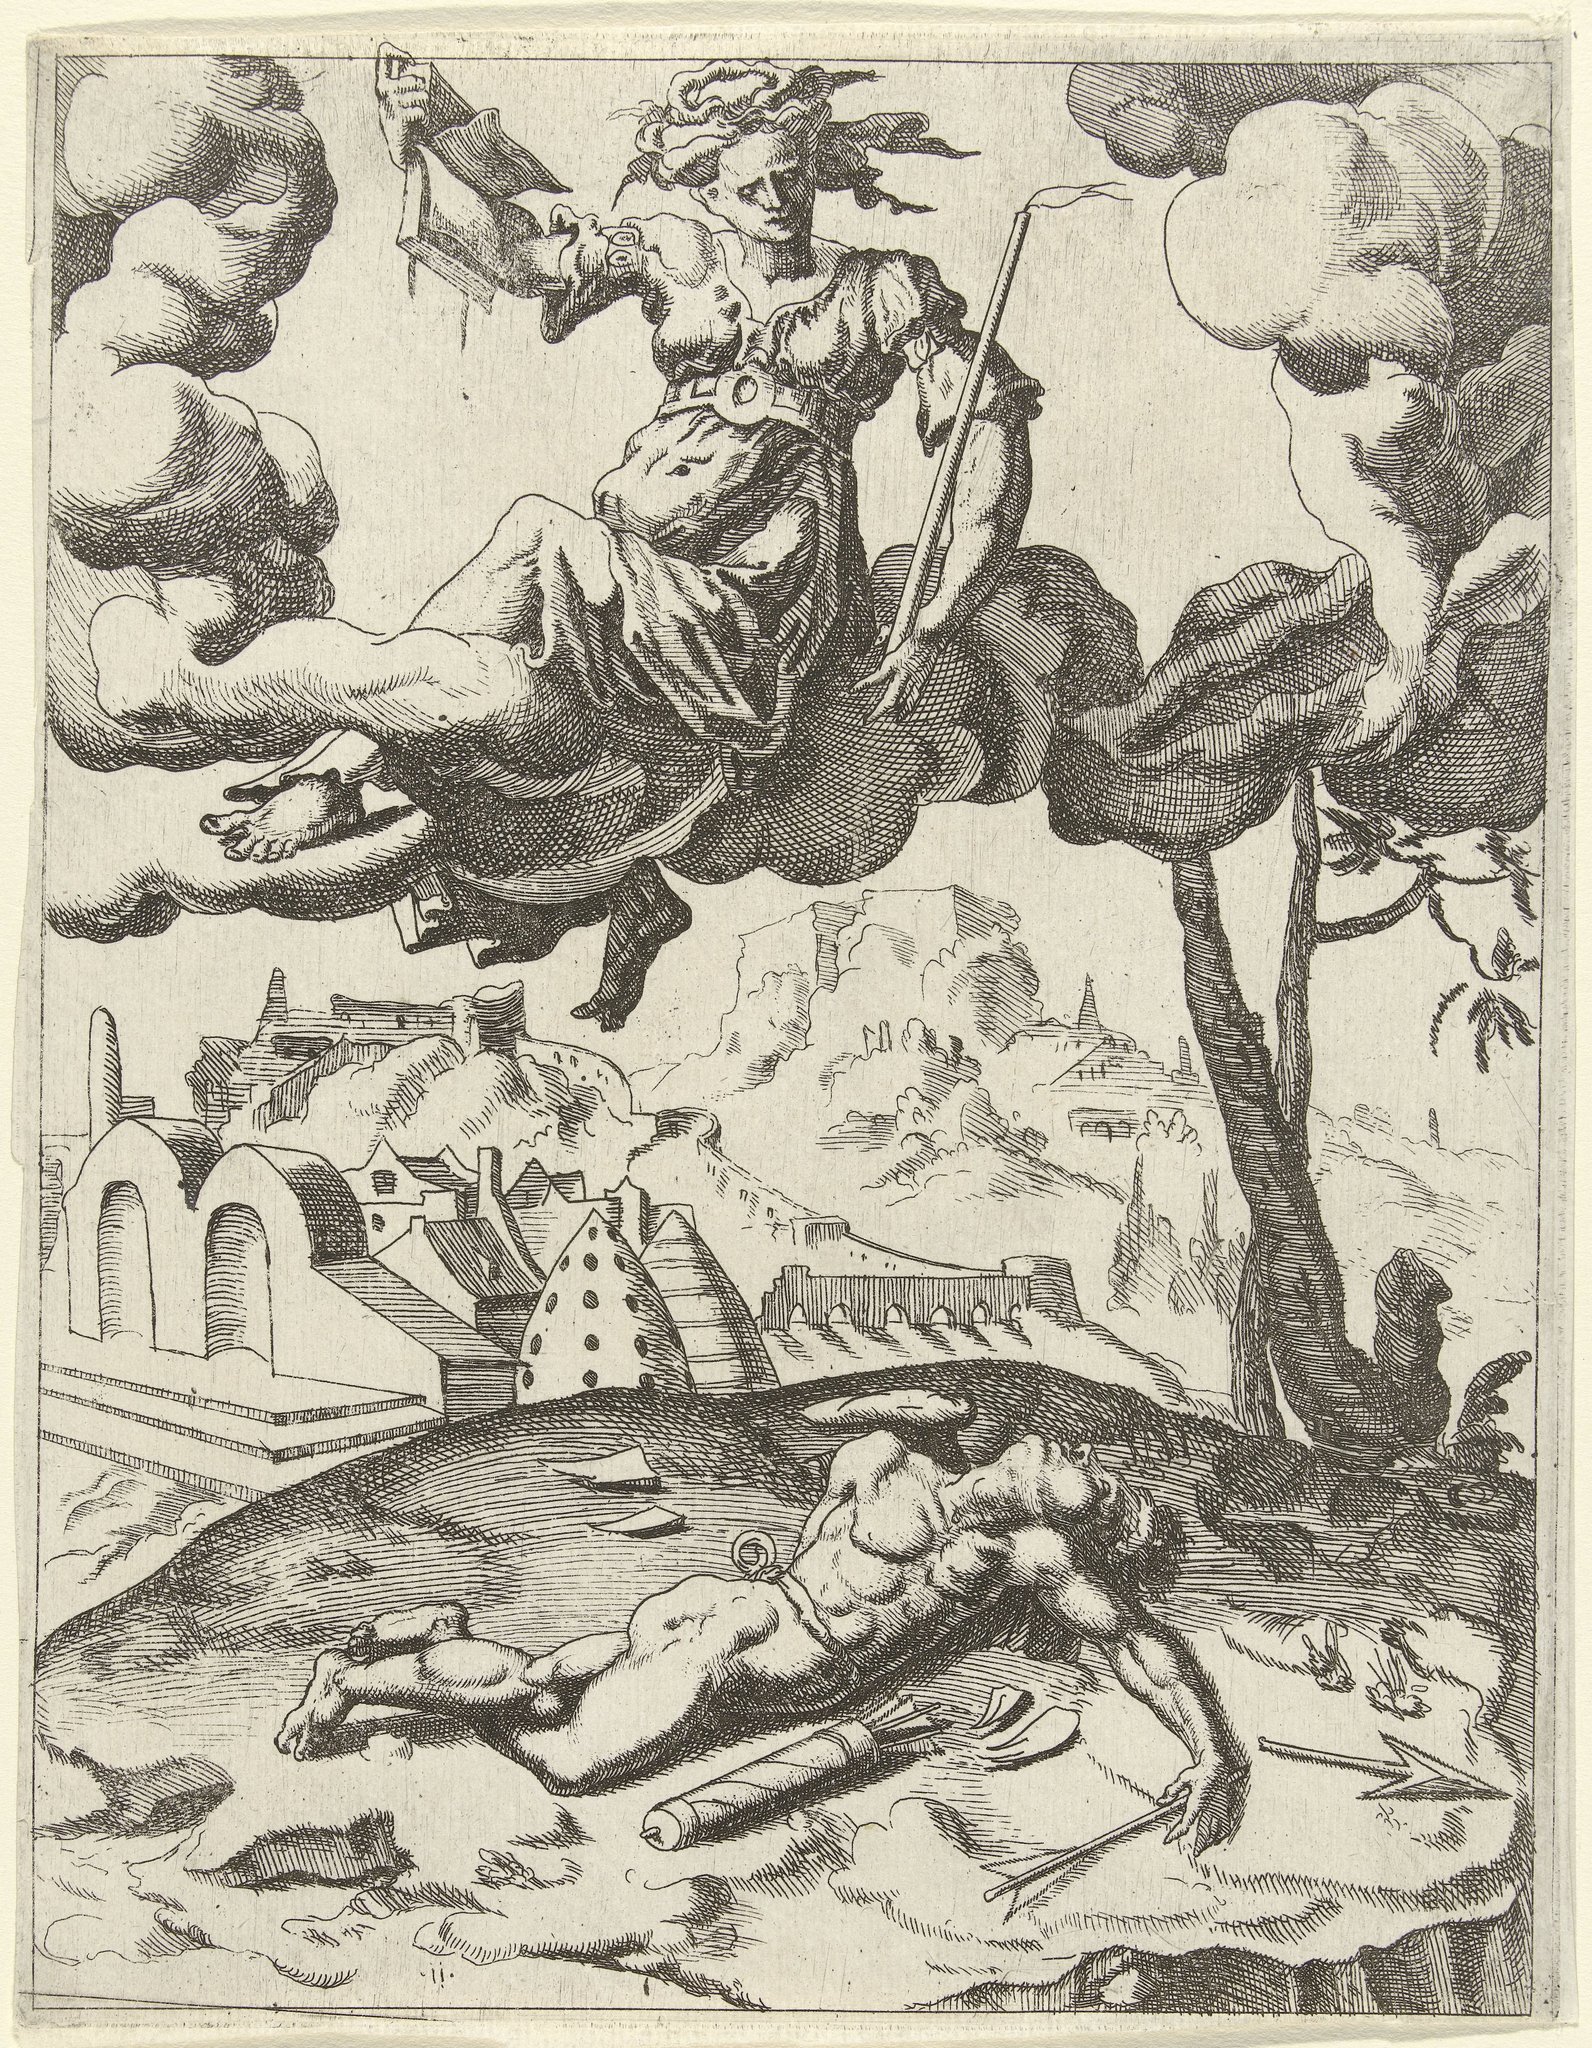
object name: print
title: Geloof overwint de zinnelijke liefde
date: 1532-1590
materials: paper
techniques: etching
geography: haarlem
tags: faith, 'fides'; 'fede', 'fede catholica', 'fede christiana', 'fede christiana catholica' (ripa) ~ one of the three theological virtues, 'trionfo della castità', 'triumphus pudicitiae'; 'carro della castità' (ripa), (story of) cupid, amor (eros)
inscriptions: collector's mark: Lugt 2760, collector's mark: Lugt 2228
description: In de wolken de personificatie van het Geloof. Ze draagt een boek in haar rechterhand en een kaars in haar linkerhand. Onder haar op de grond ligt het lijk van Cupido, zijn liefdespijl is gebroken. Het geloof is sterker dan de liefde. De prent maakt deel uit van een zesdelige serie over de triomfen van Petrarca.